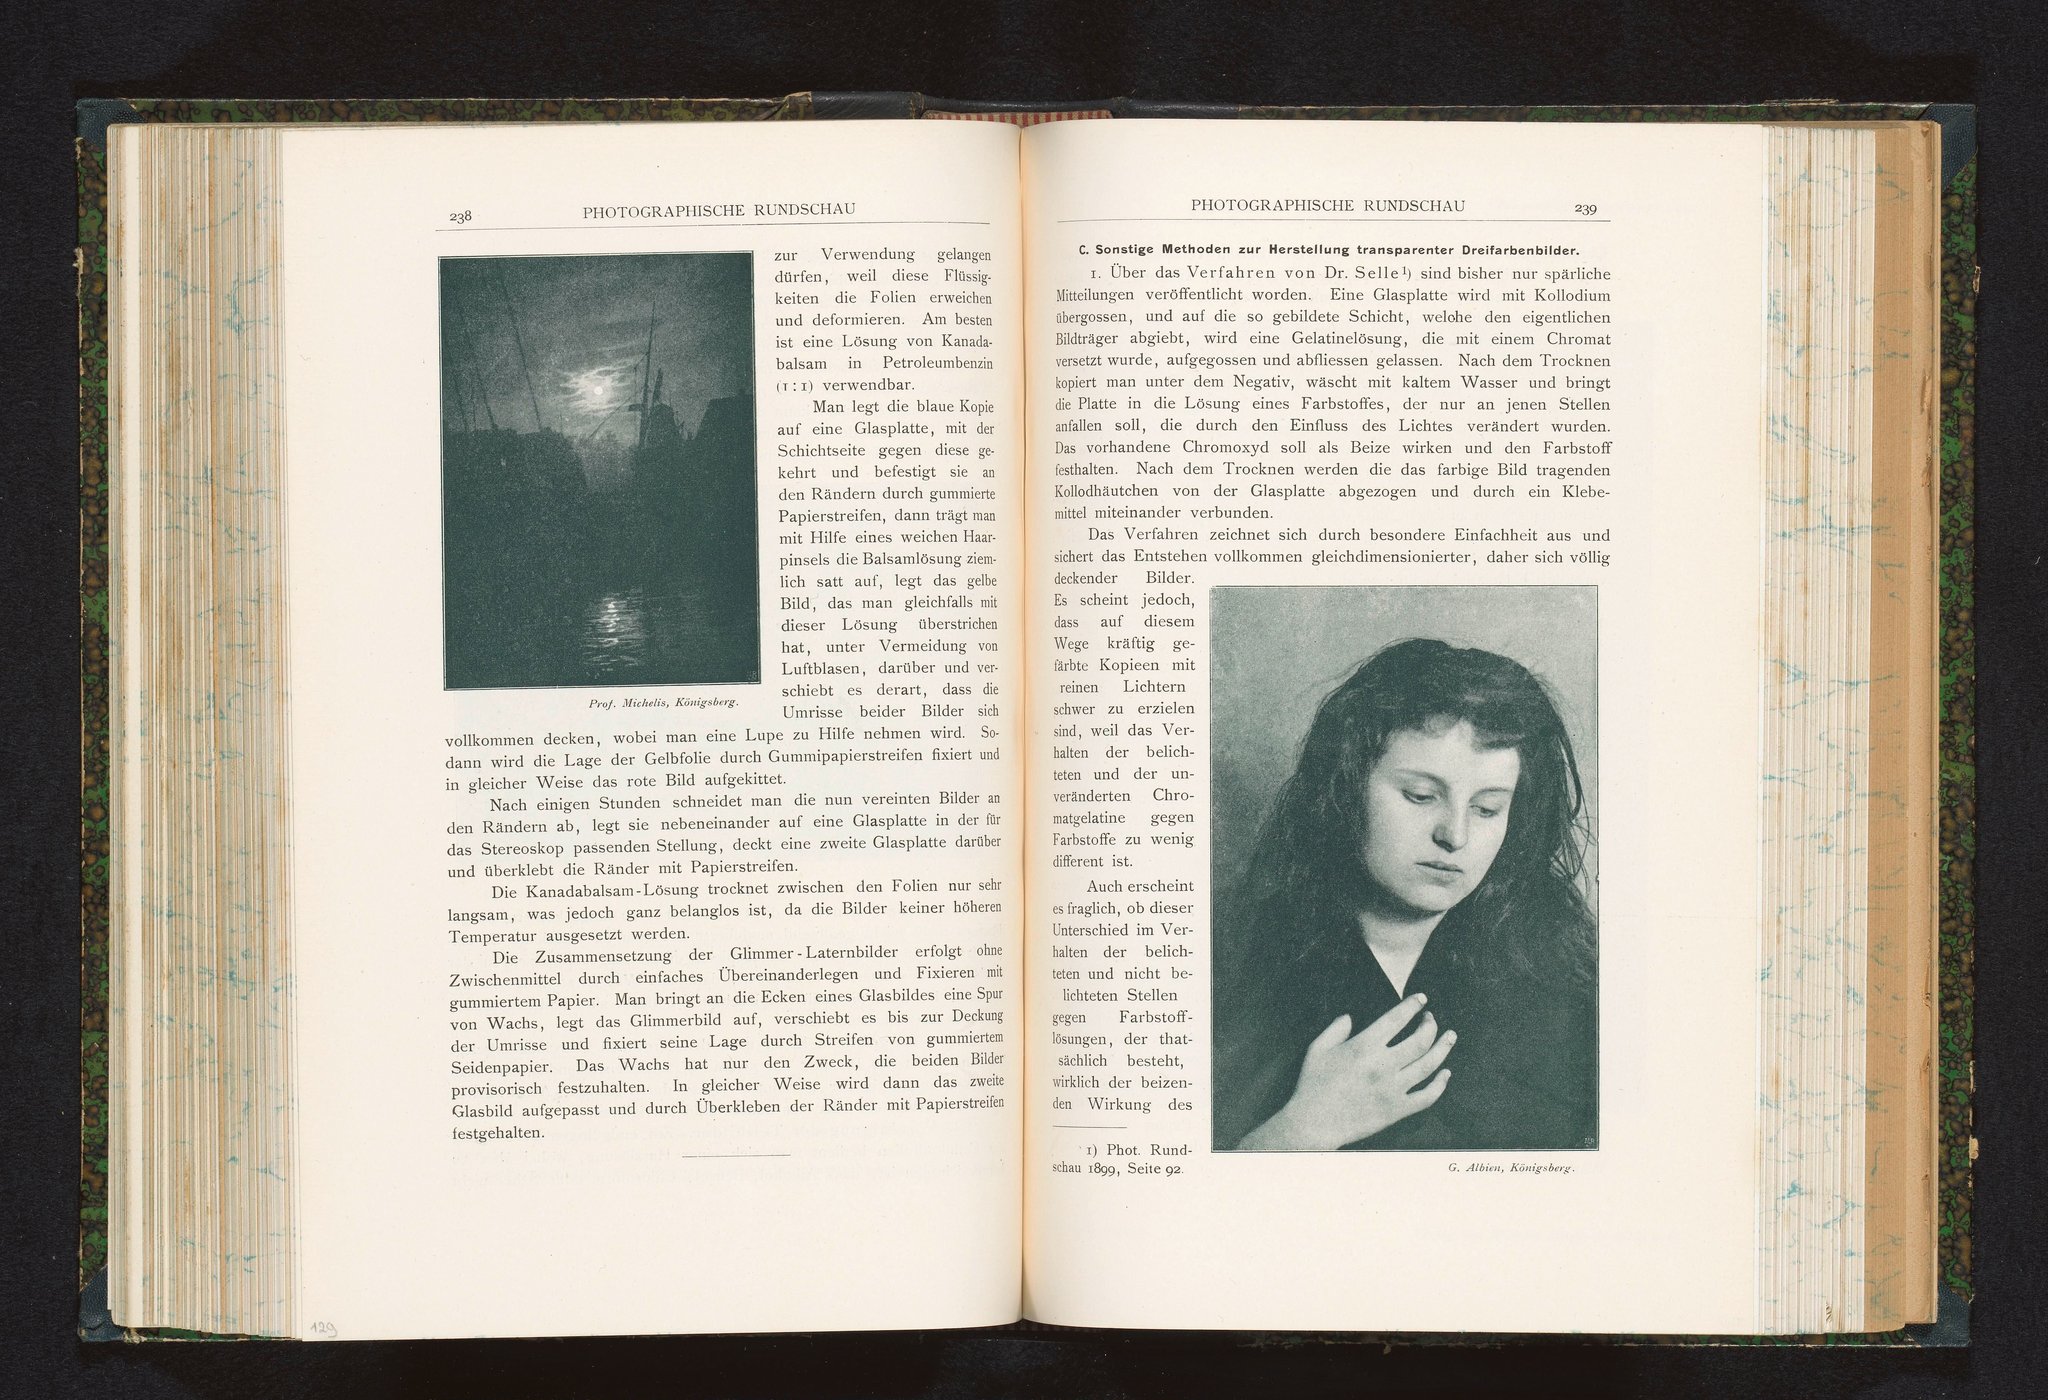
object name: page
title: Stadsgezicht met een molen bij maanlicht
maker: michelis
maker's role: fotograaf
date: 1894-1899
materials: paper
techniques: autotype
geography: berlin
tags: city-view, and landscape with man-made constructions, windmill